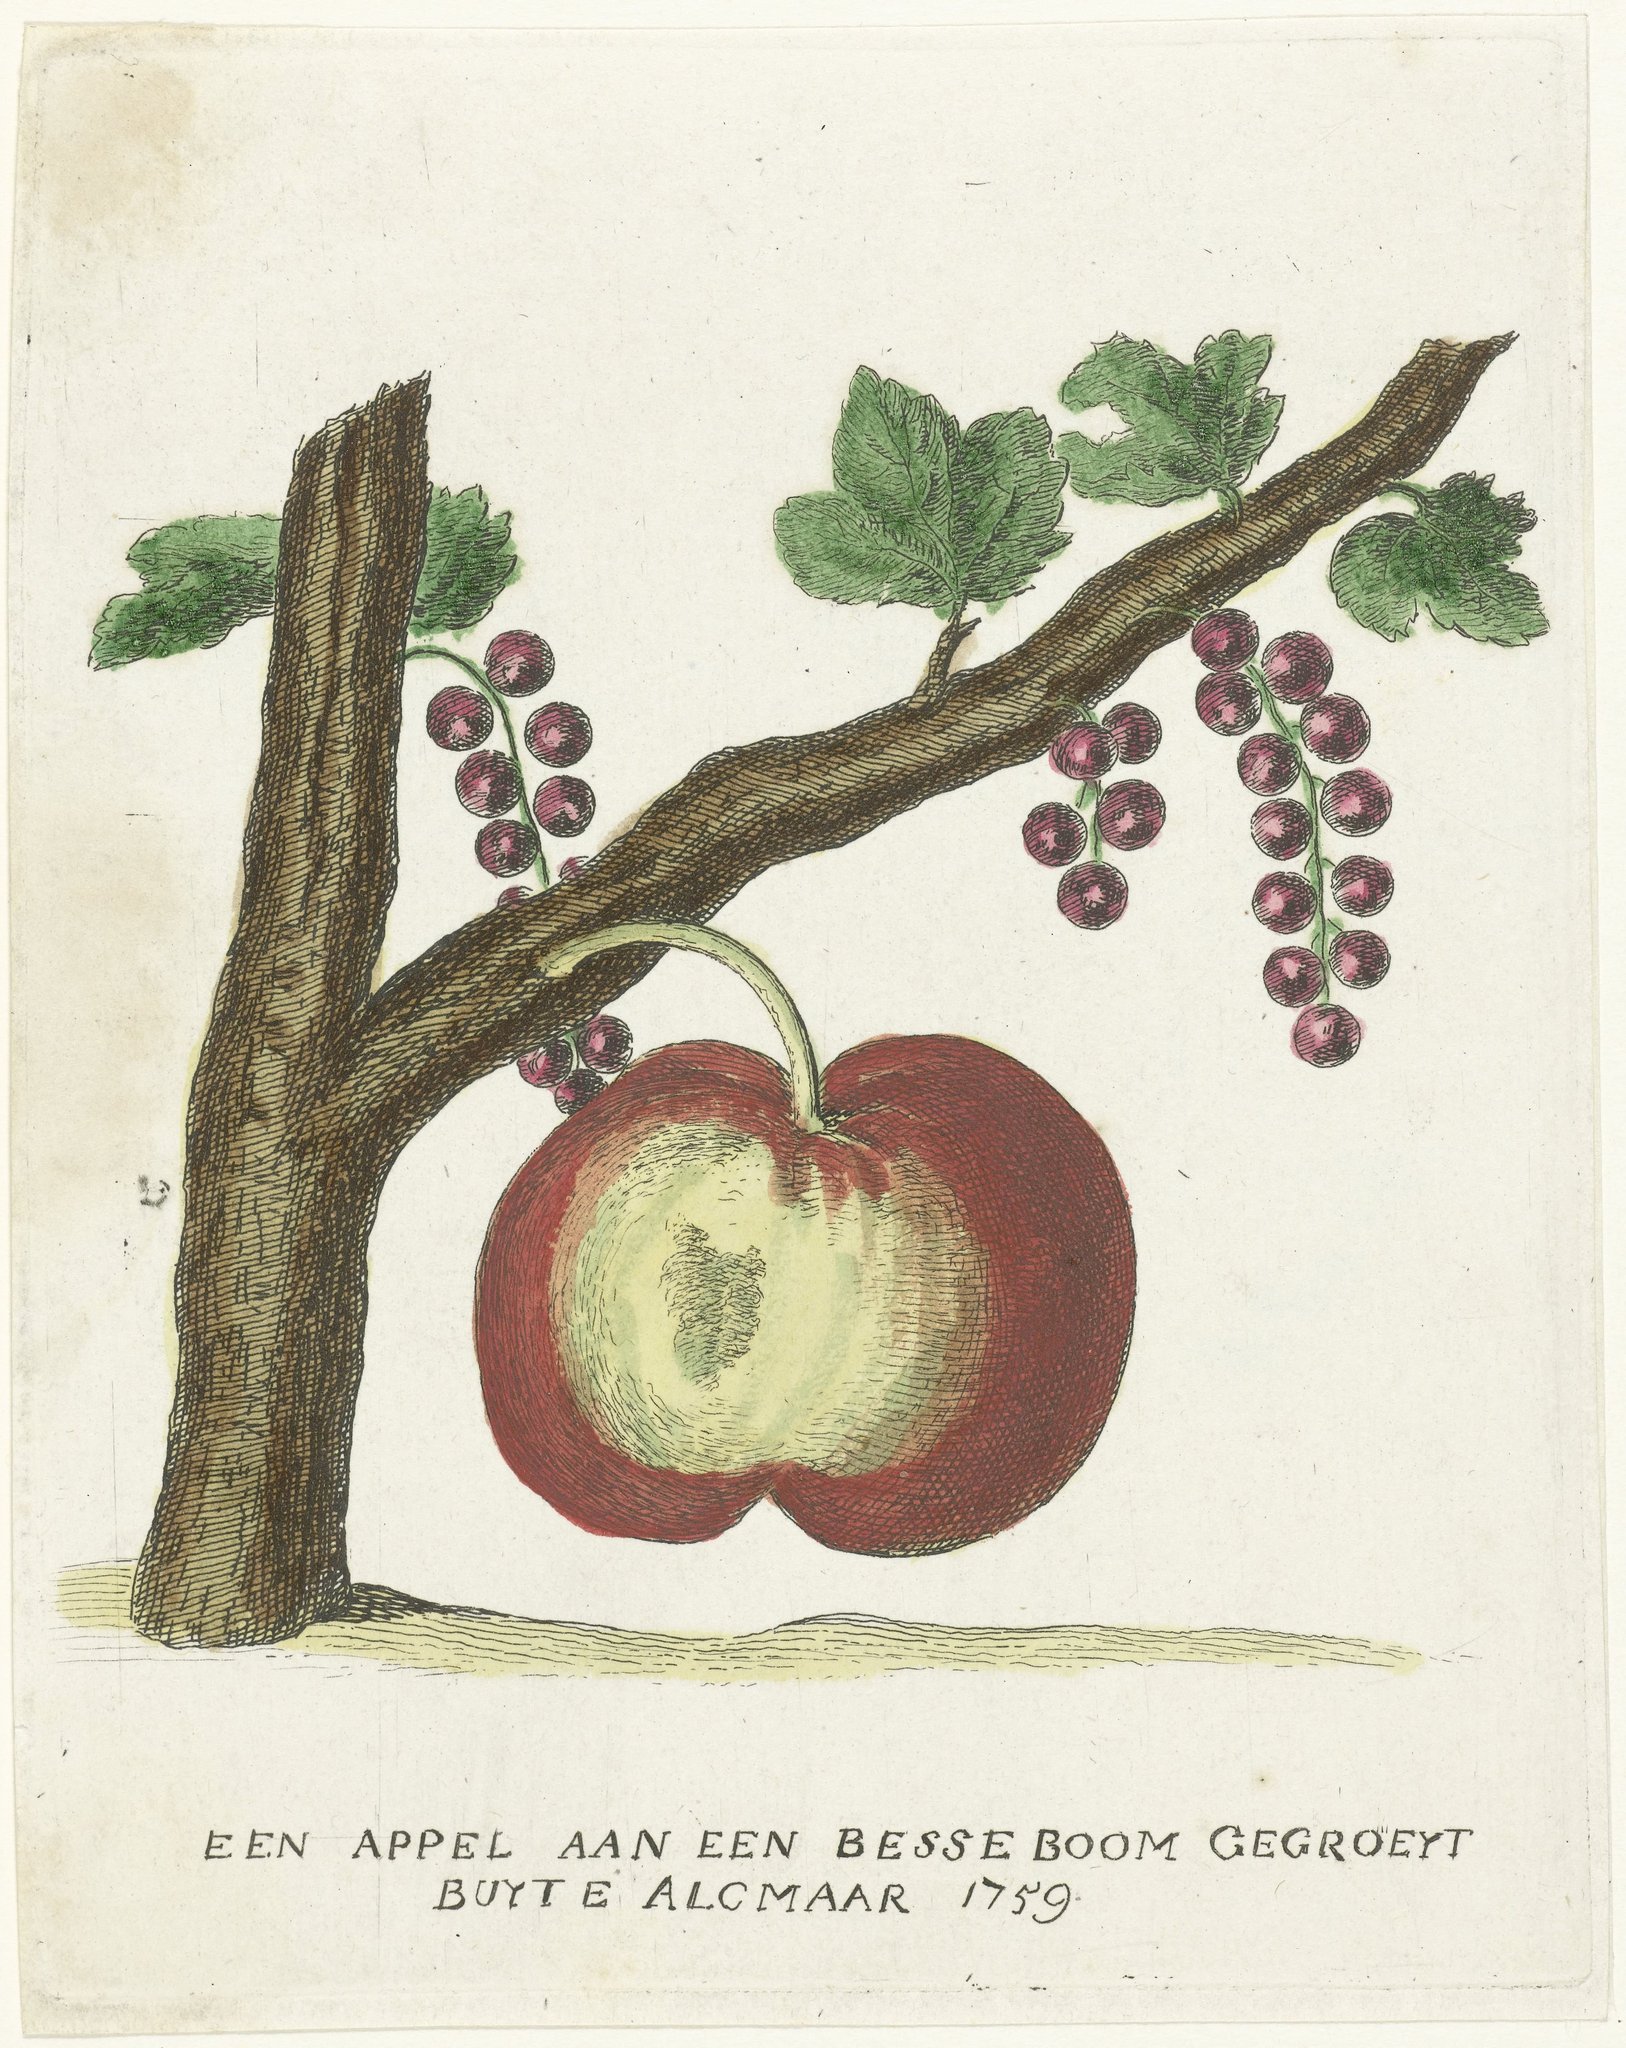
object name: print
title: Appel groeiend aan een bessenstruik, 1759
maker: Anonymous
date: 1759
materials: paper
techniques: etching, hand coloring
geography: northern netherlands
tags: fabulous plants (in general)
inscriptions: collector's mark: Lugt 2228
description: Wonderlijke verschijnsel van een appel groeiend aan een rode-bessenstruik, buiten Alkmaar, 1759.